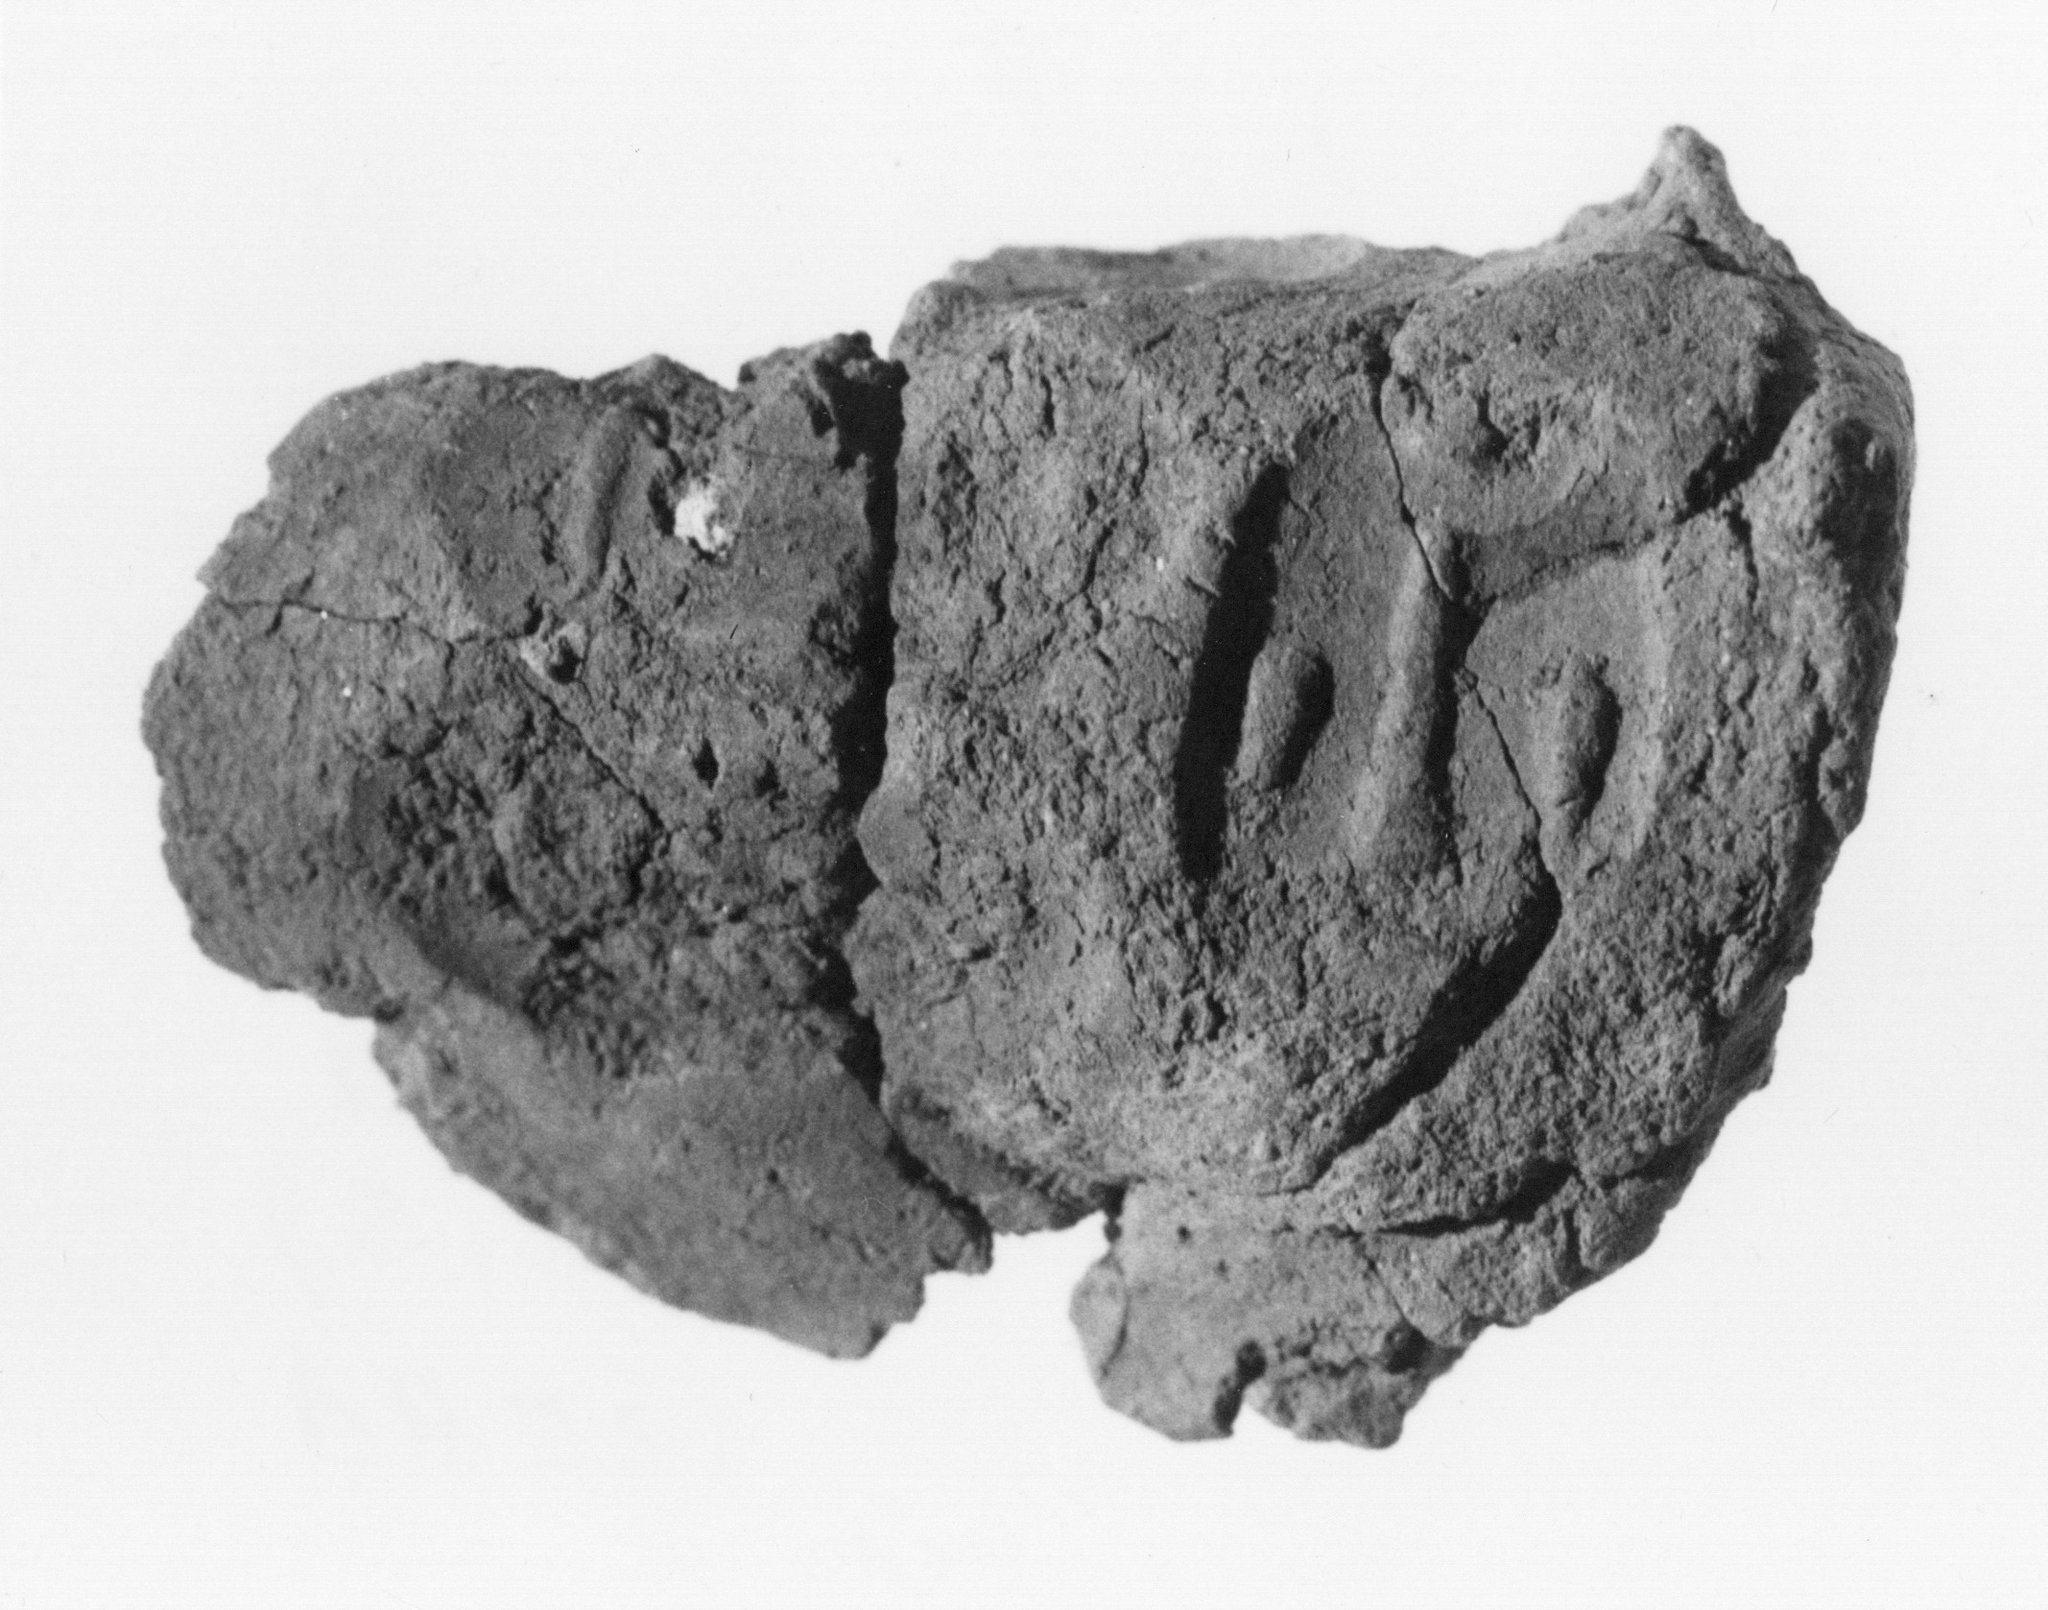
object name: sealing, djed, cobra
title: Document Sealing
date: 1390-1352 BCE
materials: mud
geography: egypt